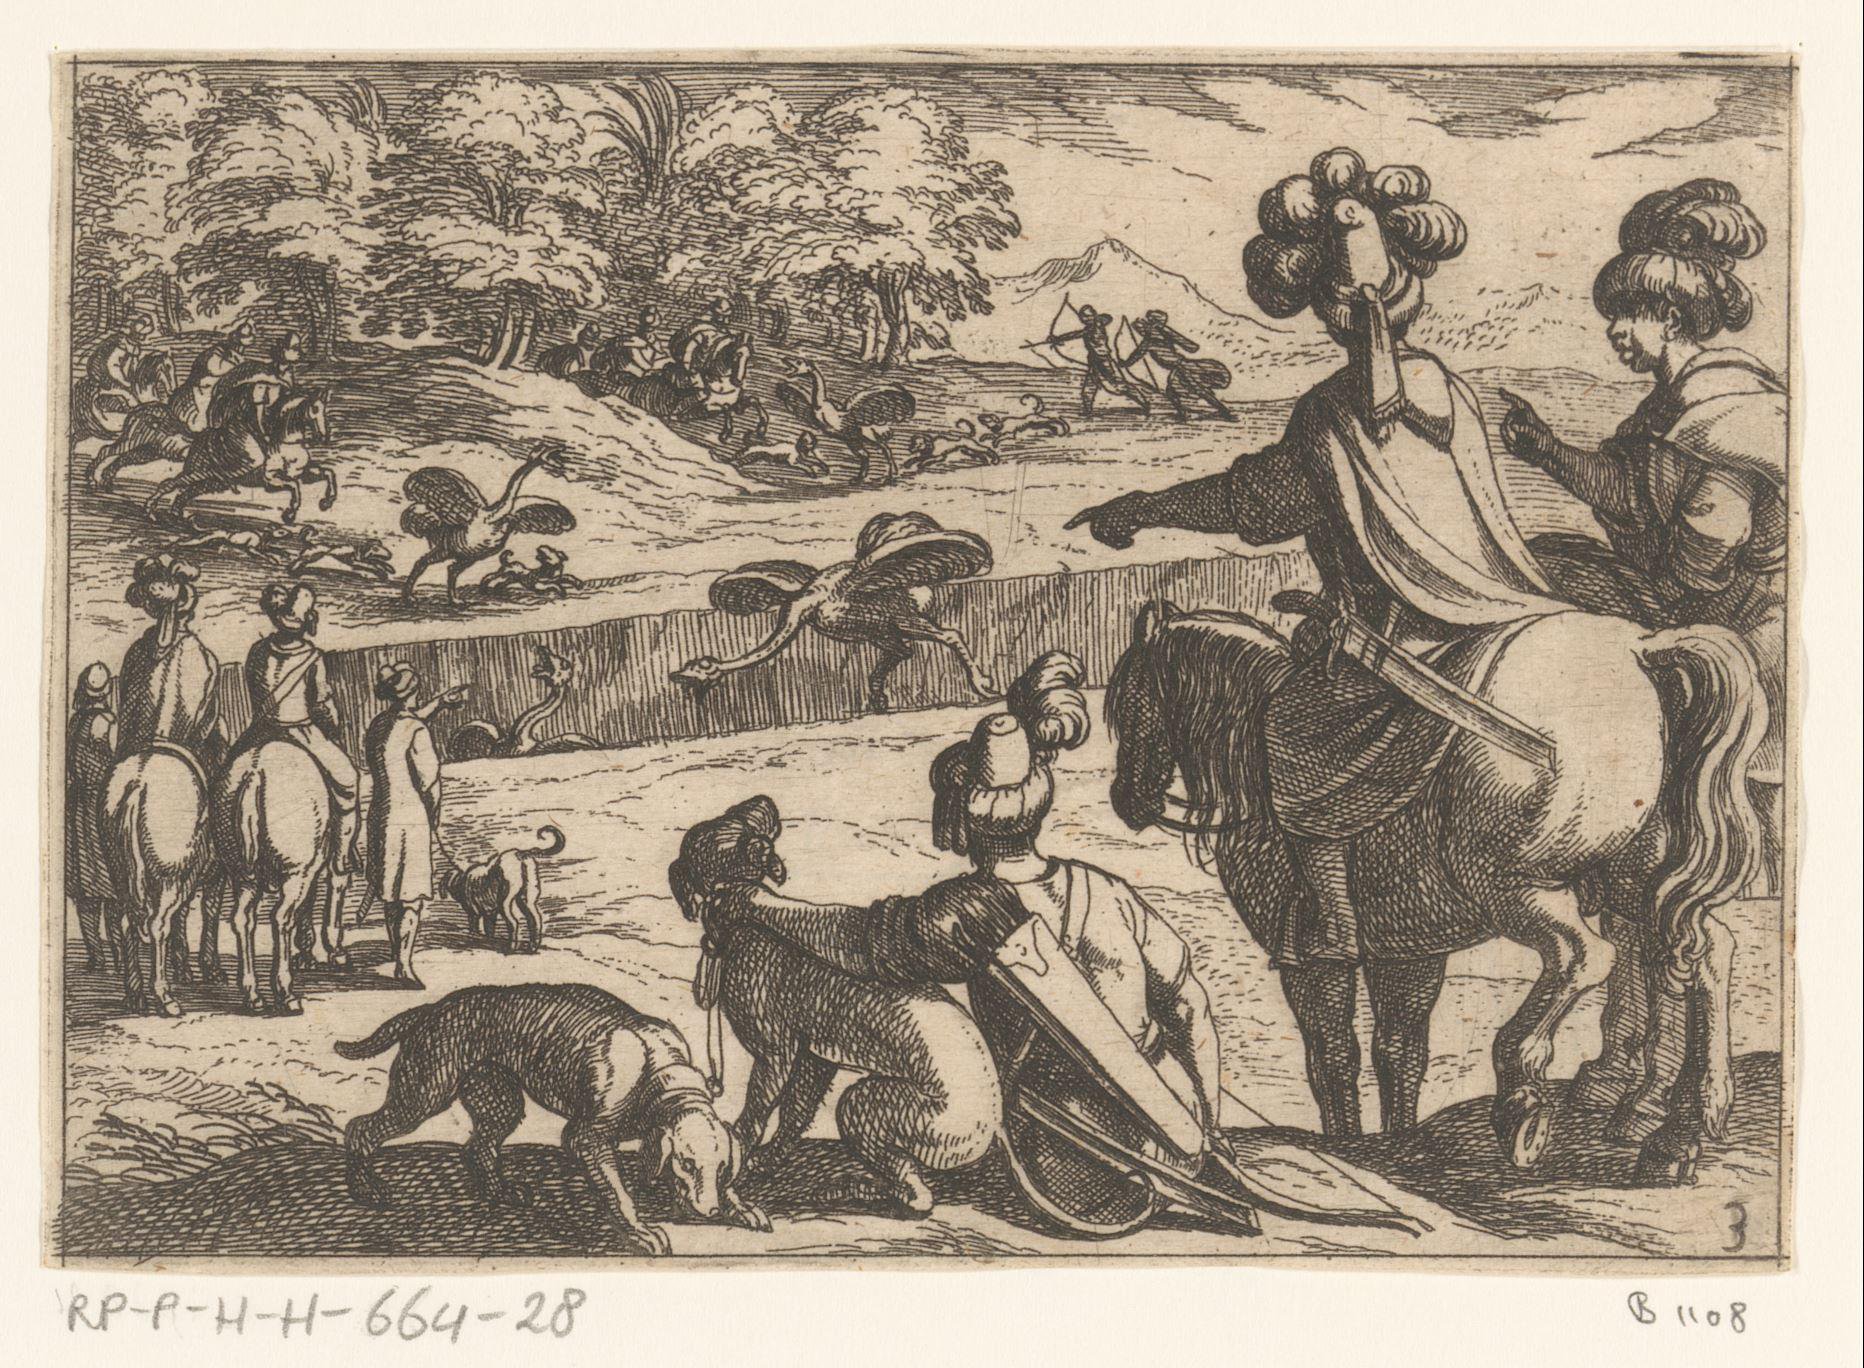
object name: print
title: Jachtscènes (deel 3)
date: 1598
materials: paper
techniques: etching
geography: vatican city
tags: walker and runner birds: ostrich, hunter, hunters hunting (n.b.: in 1988-1990 this notation denoted the concept of 43c11421 'hunters resting during the hunt'), bird hunting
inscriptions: collector's mark: ‘Hinloopen’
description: Deze prent maakt deel uit van een reeks van vijftien prenten met jachtscènes (+ opdracht).